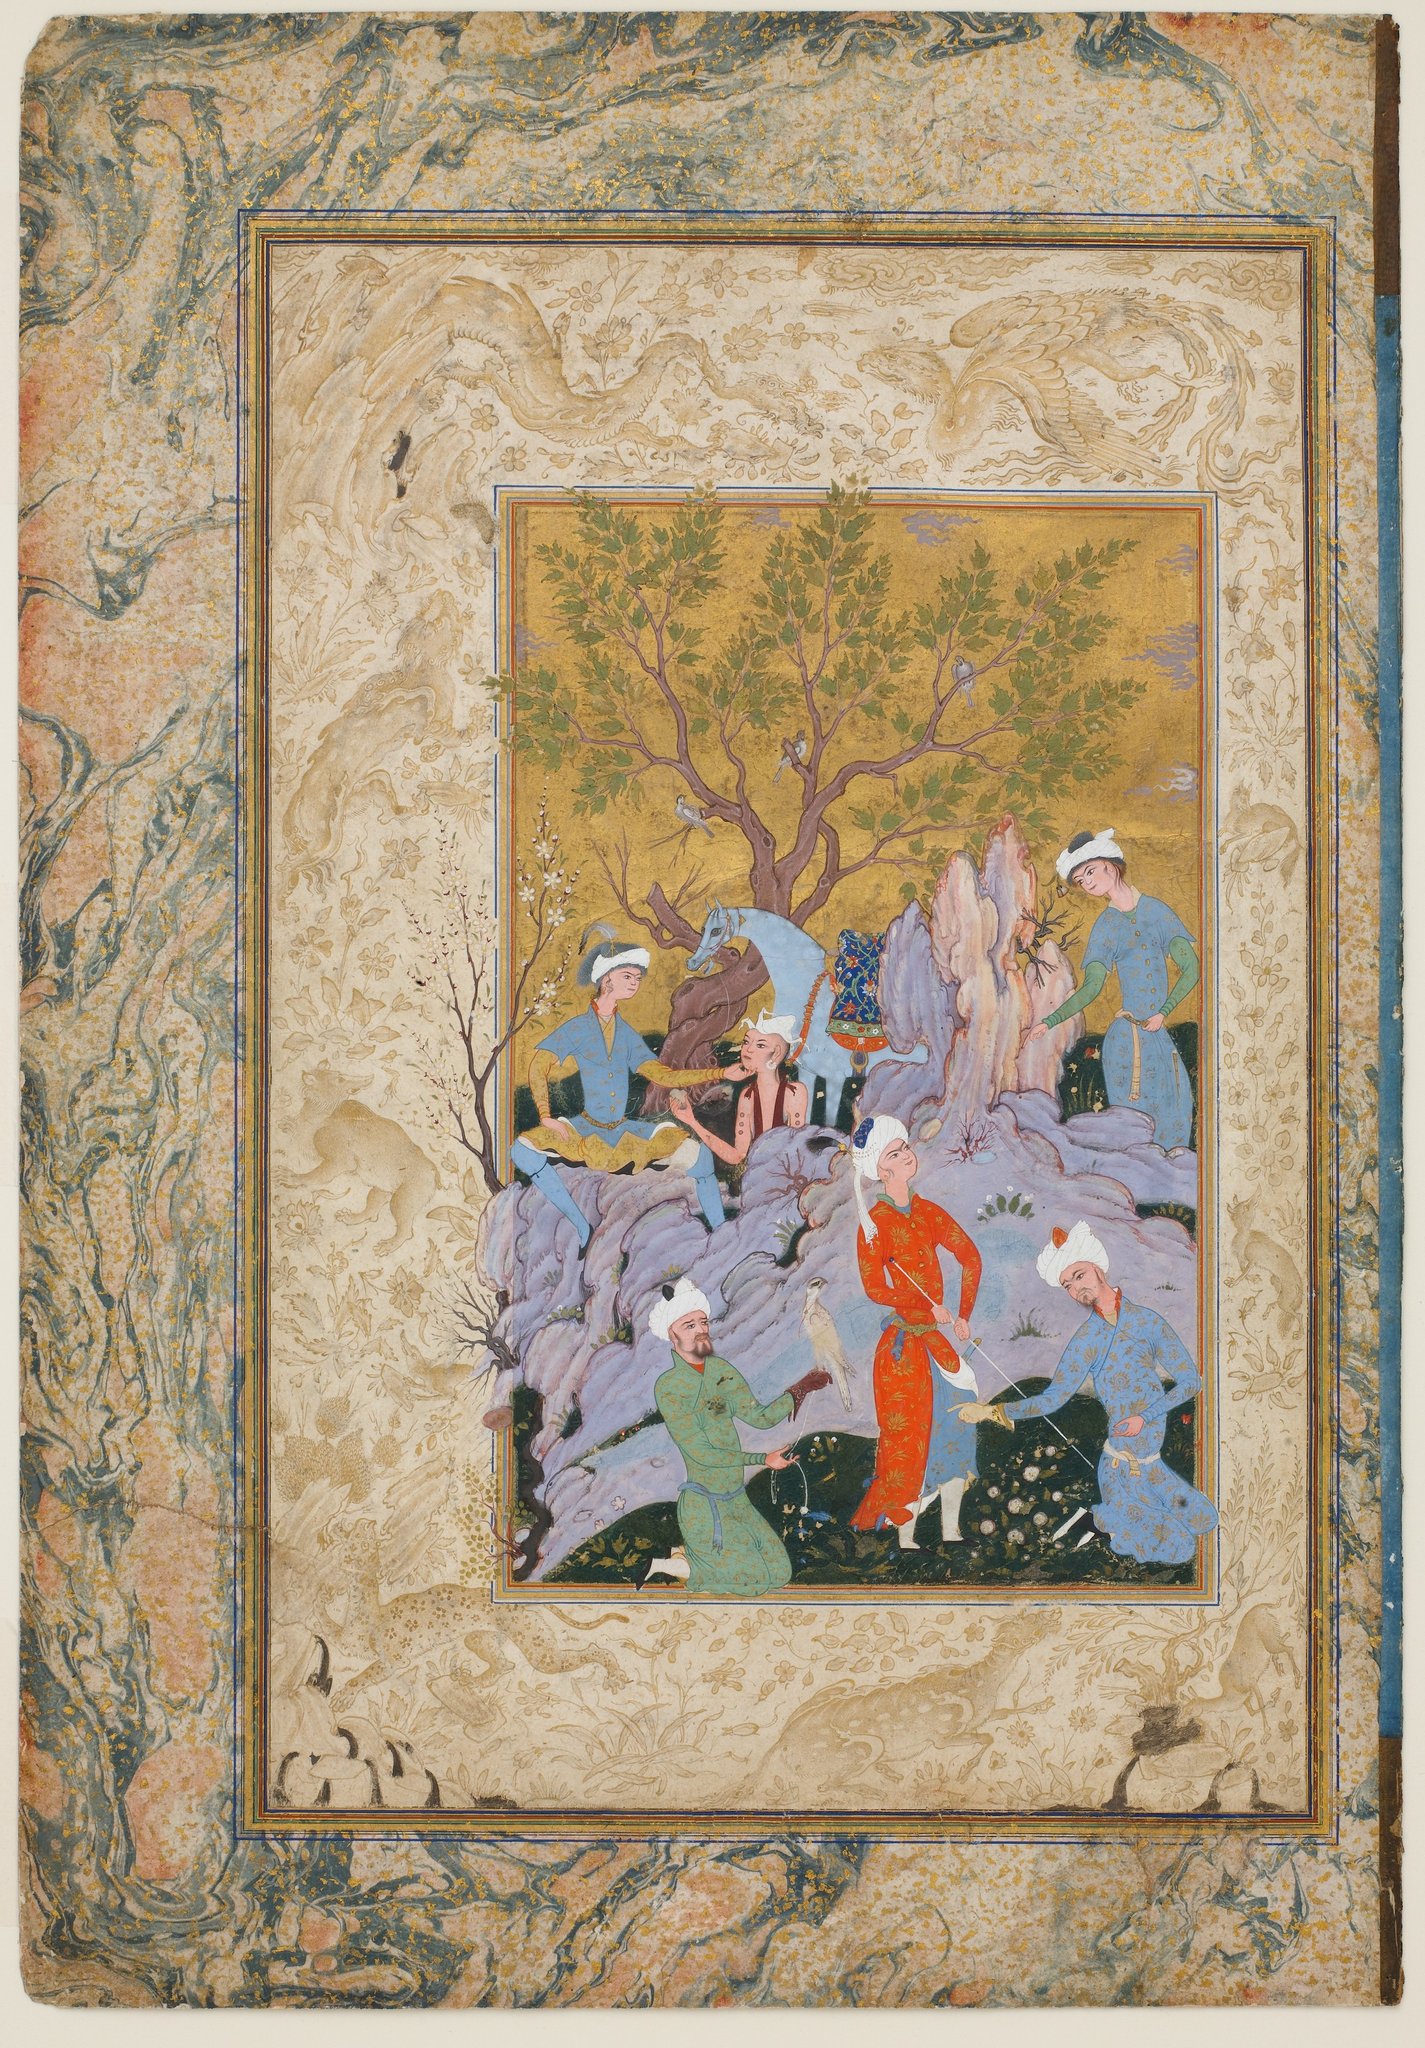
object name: folio from an illustrated manuscript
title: Princely Hawking Party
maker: mirza 'ali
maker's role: artist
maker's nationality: iranian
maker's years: 1500-1599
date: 1570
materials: gold, ink, paper, watercolor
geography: iran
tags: animals,birds,hawks,boys,men,horses